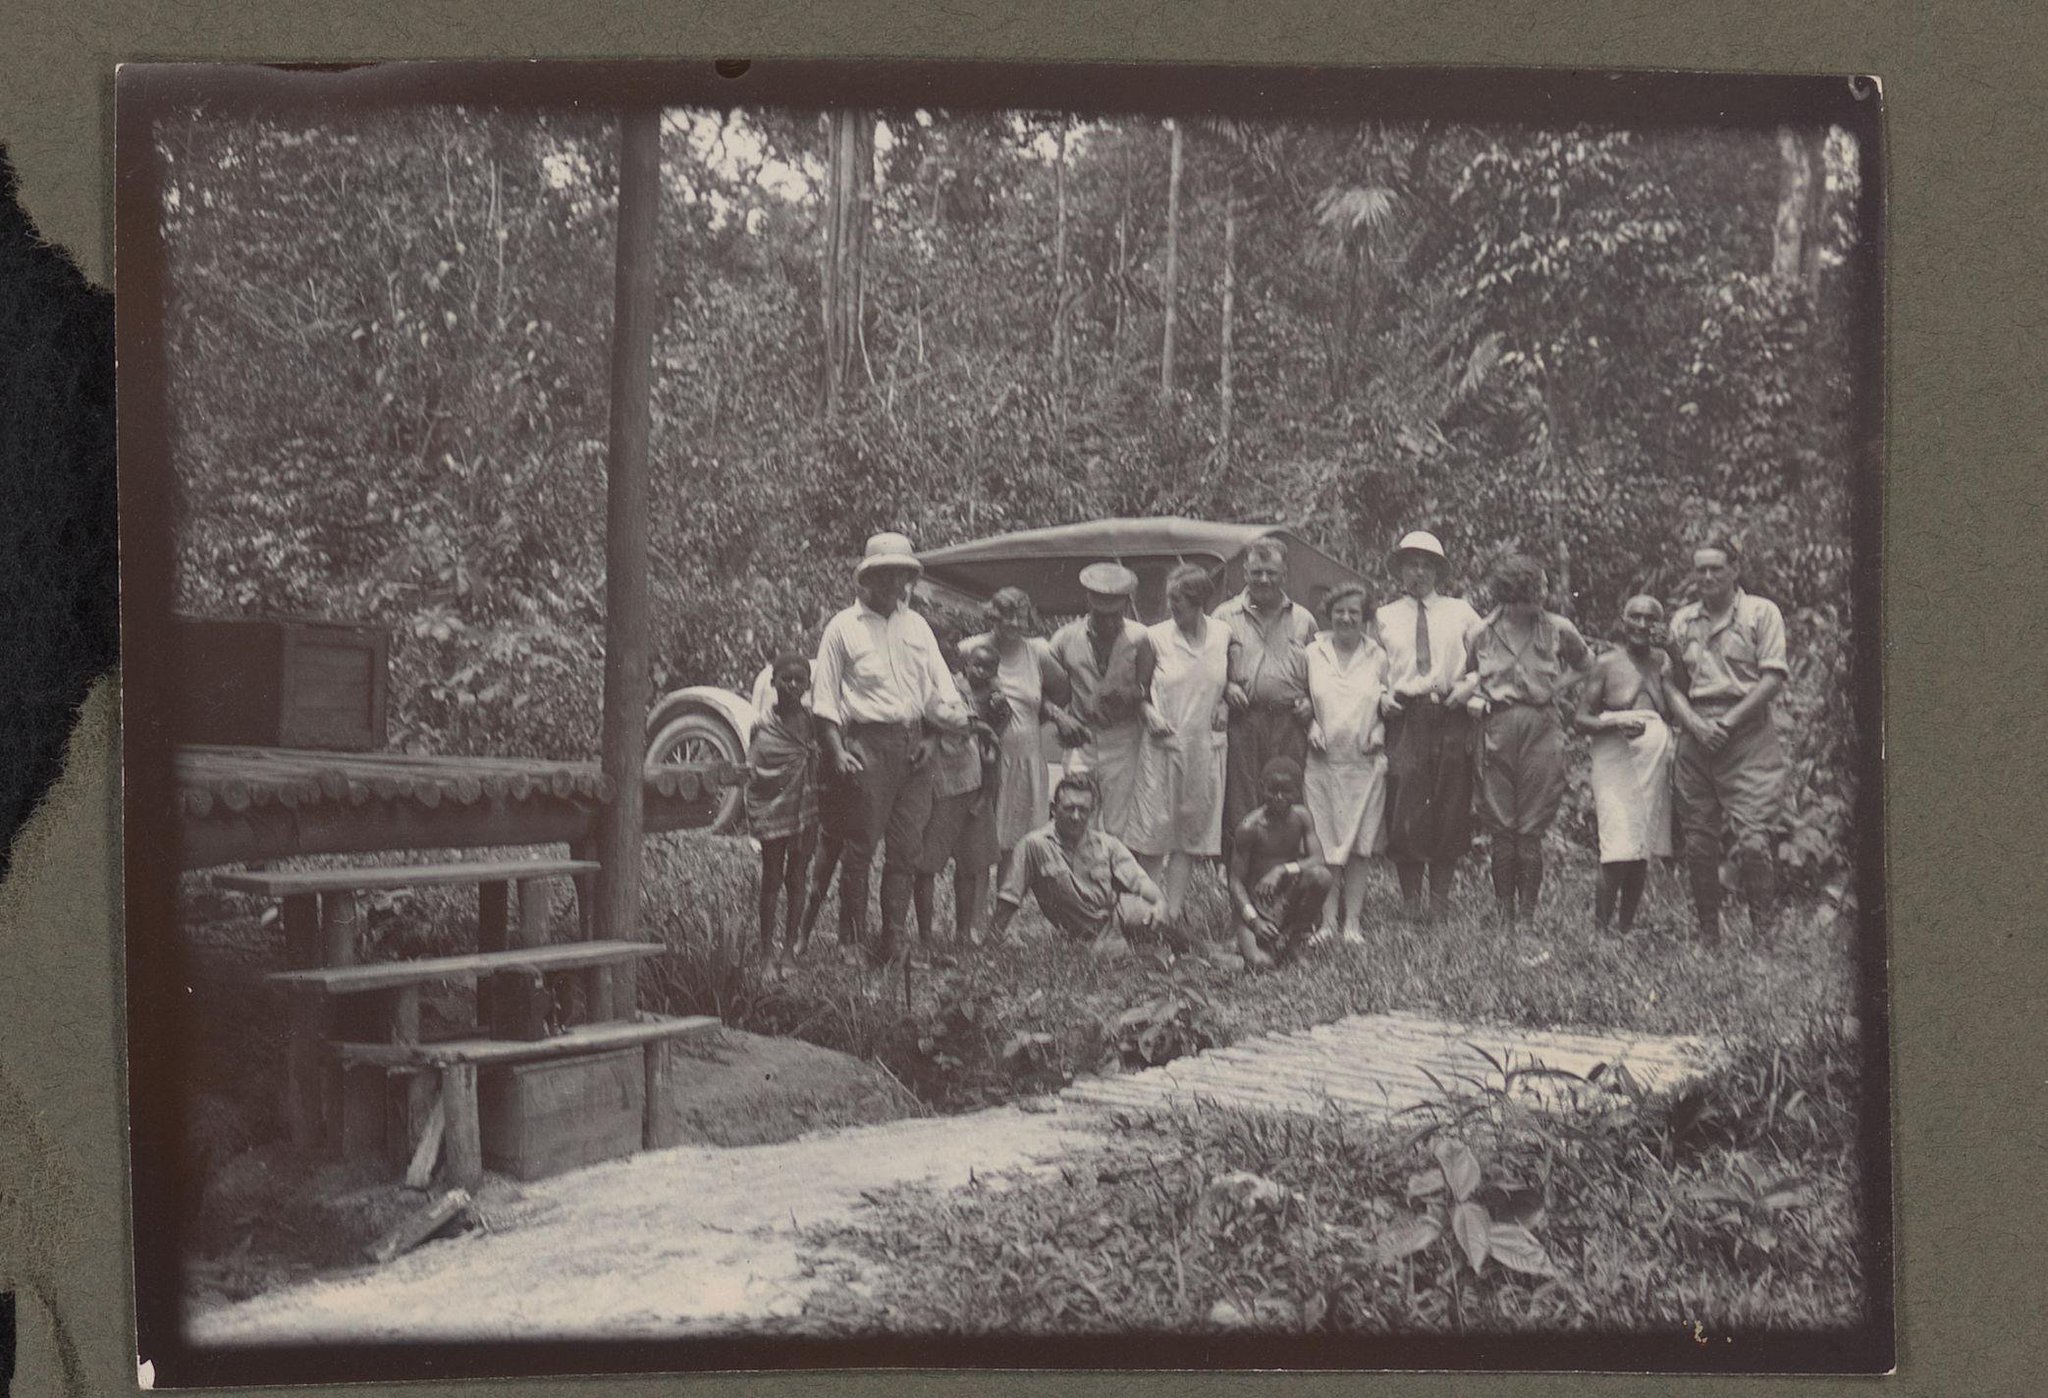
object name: photograph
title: Bezoek aan een inlands dorp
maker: Anonymous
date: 1925-1927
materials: photographic support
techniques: photography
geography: suriname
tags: jetten, familie, moengo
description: Bezoek aan een inlands dorp door een groep Nederlanders waaronder het echtpaar Jetten. Foto op een bladzijde van een los albumblad waarvan een hoek met twee foto's is uitgescheurd. Onderdeel van het ensemble met foto's van de familie van ingenieur Jetten in de mijnbouwstad Moengo in Suriname.